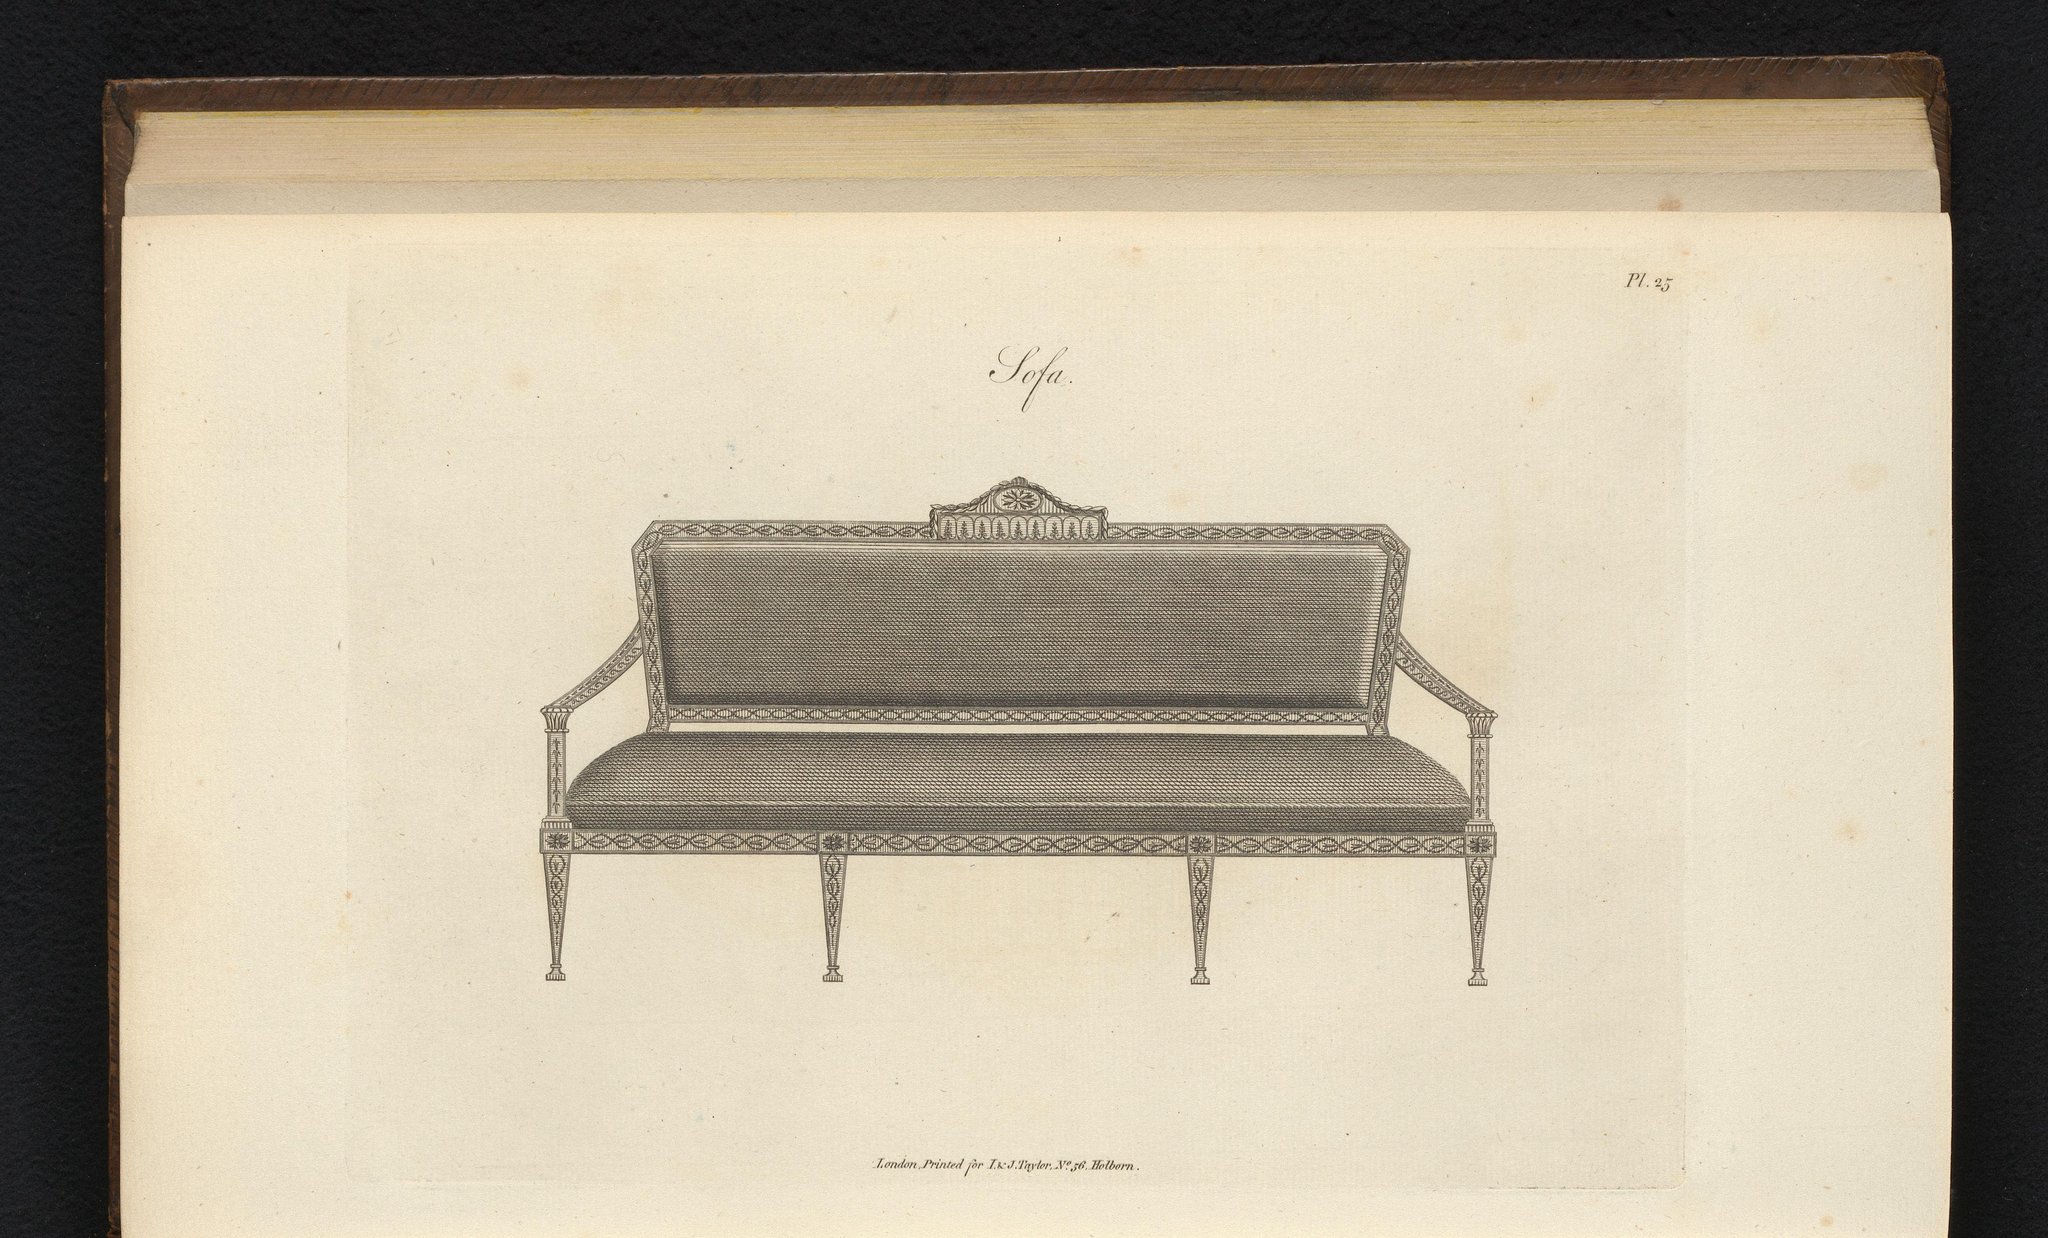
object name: page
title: Sofa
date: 1787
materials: paper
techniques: engraving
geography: holborn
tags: couch, sofa, settee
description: Genummerd: Pl. 25. Bank gemerkt: C. Prent maakt deel uit van een boek.